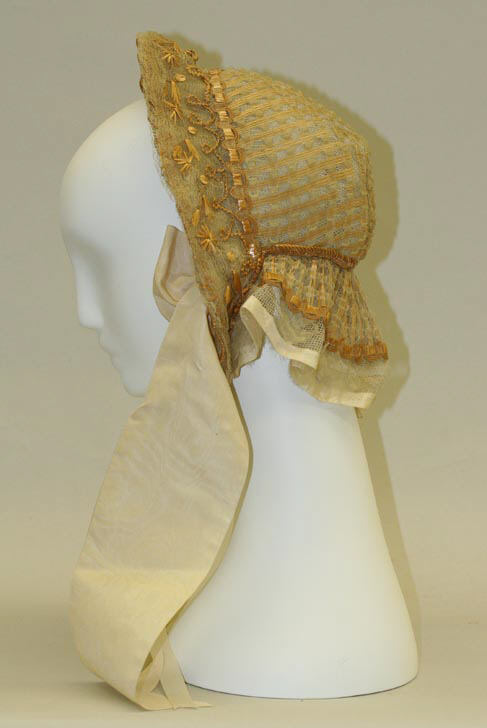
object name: bonnet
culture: american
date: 1850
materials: hair, silk, fiber